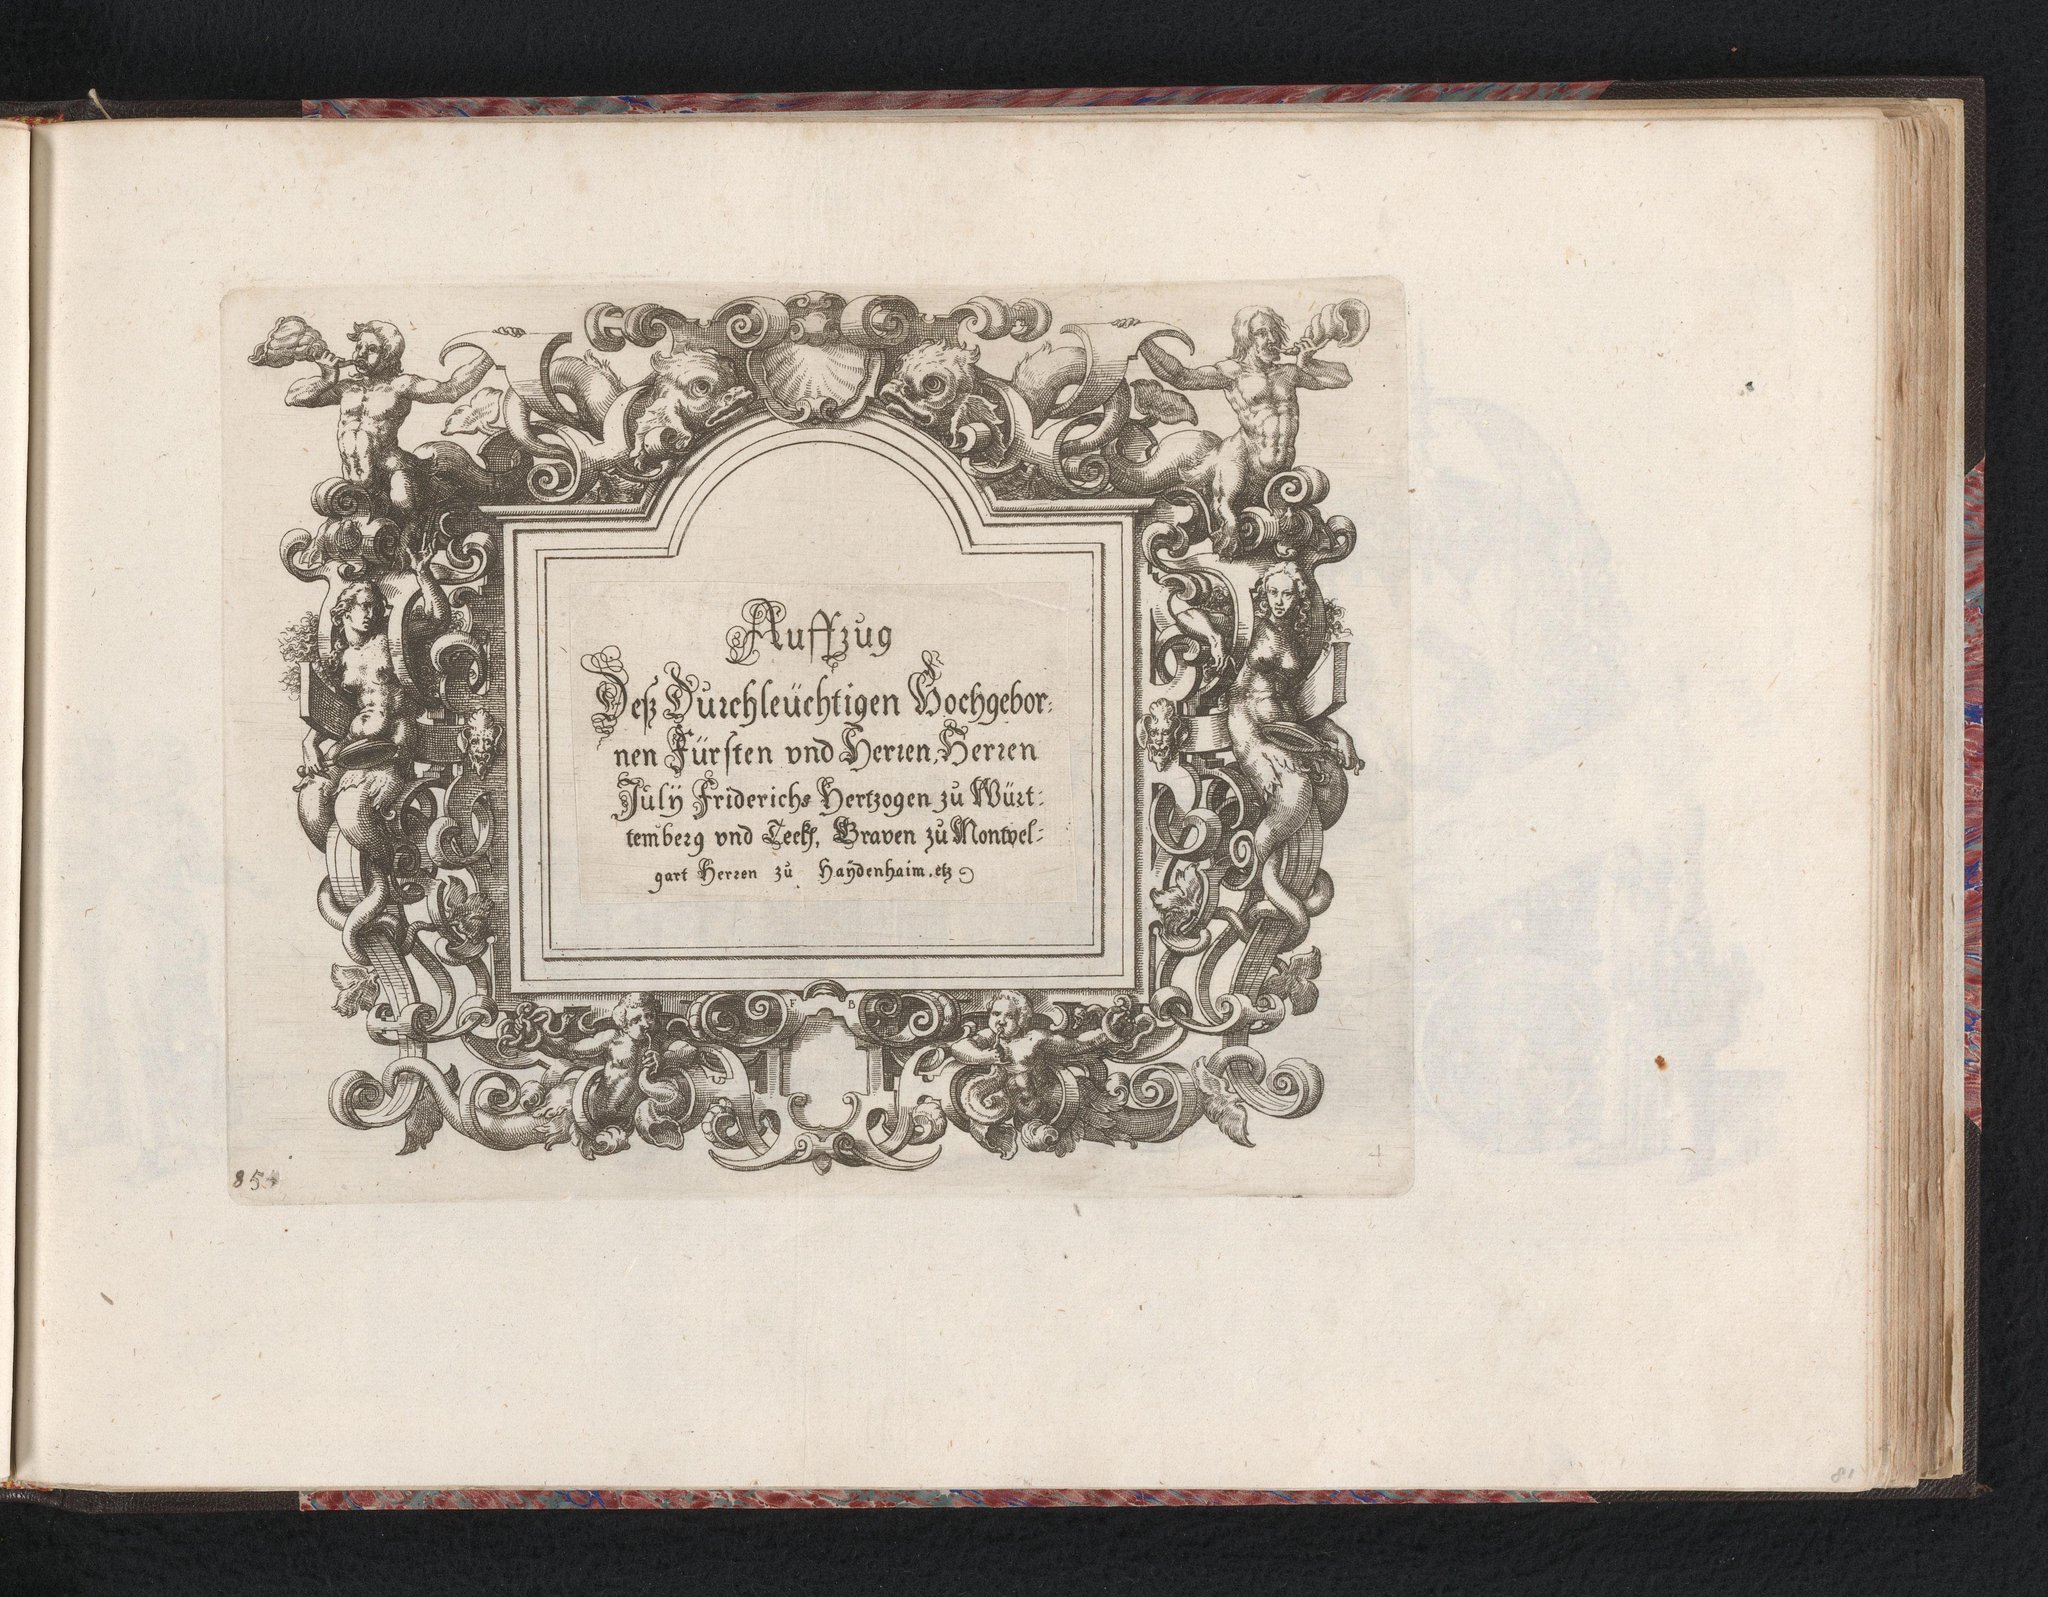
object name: print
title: Aigentliche wahrhaffte Delineation unnd Abbildung aller fürstlichen Auffzüg und Rütterspilen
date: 1618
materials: paper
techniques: etching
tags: julius friedrich württemberg (hertog), ornament ~ hybrid beings; human and animal forms mixed, 'laub- und bandelwerk' ~ ornament, monsters of the sea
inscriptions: annotation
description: Tekst in het Duits in de cartouche. Deze prent maakt deel uit van een album.